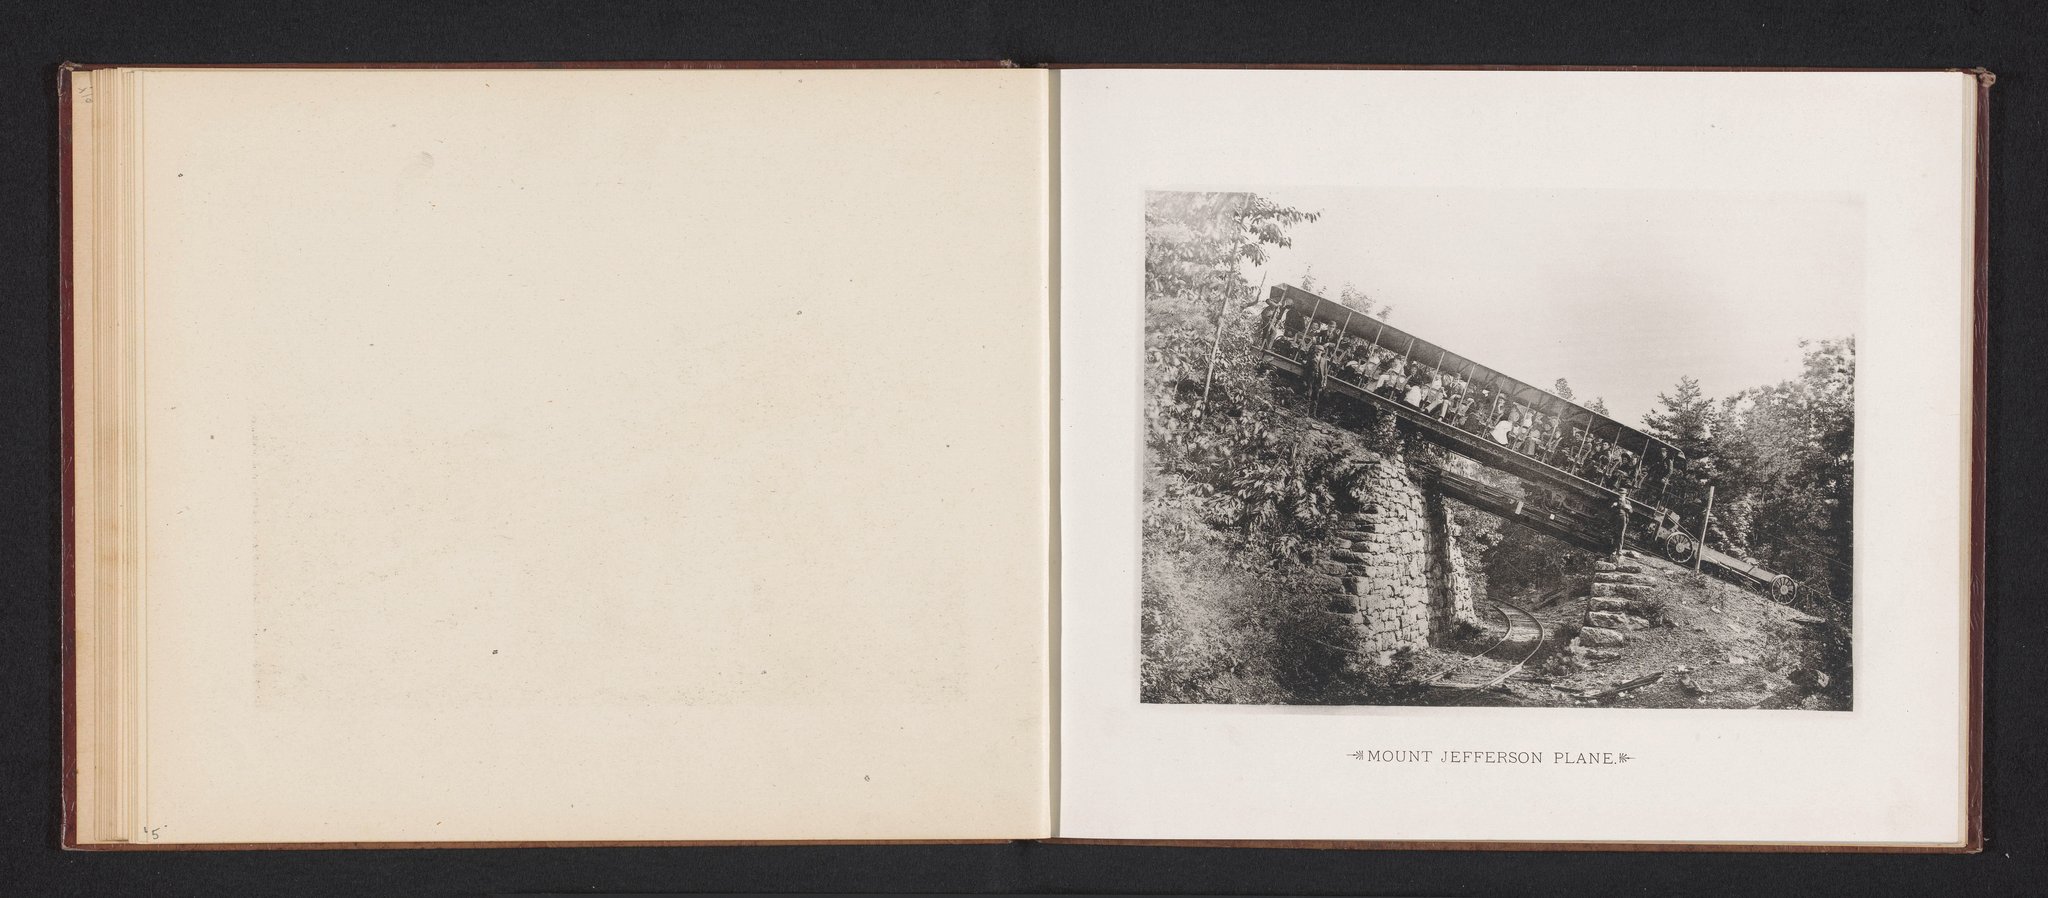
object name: photomechanical print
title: Gezicht op een kabeltram op Mount Jefferson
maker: Anonymous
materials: paper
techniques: photograph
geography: oregon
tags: tram, railway, train, mountains